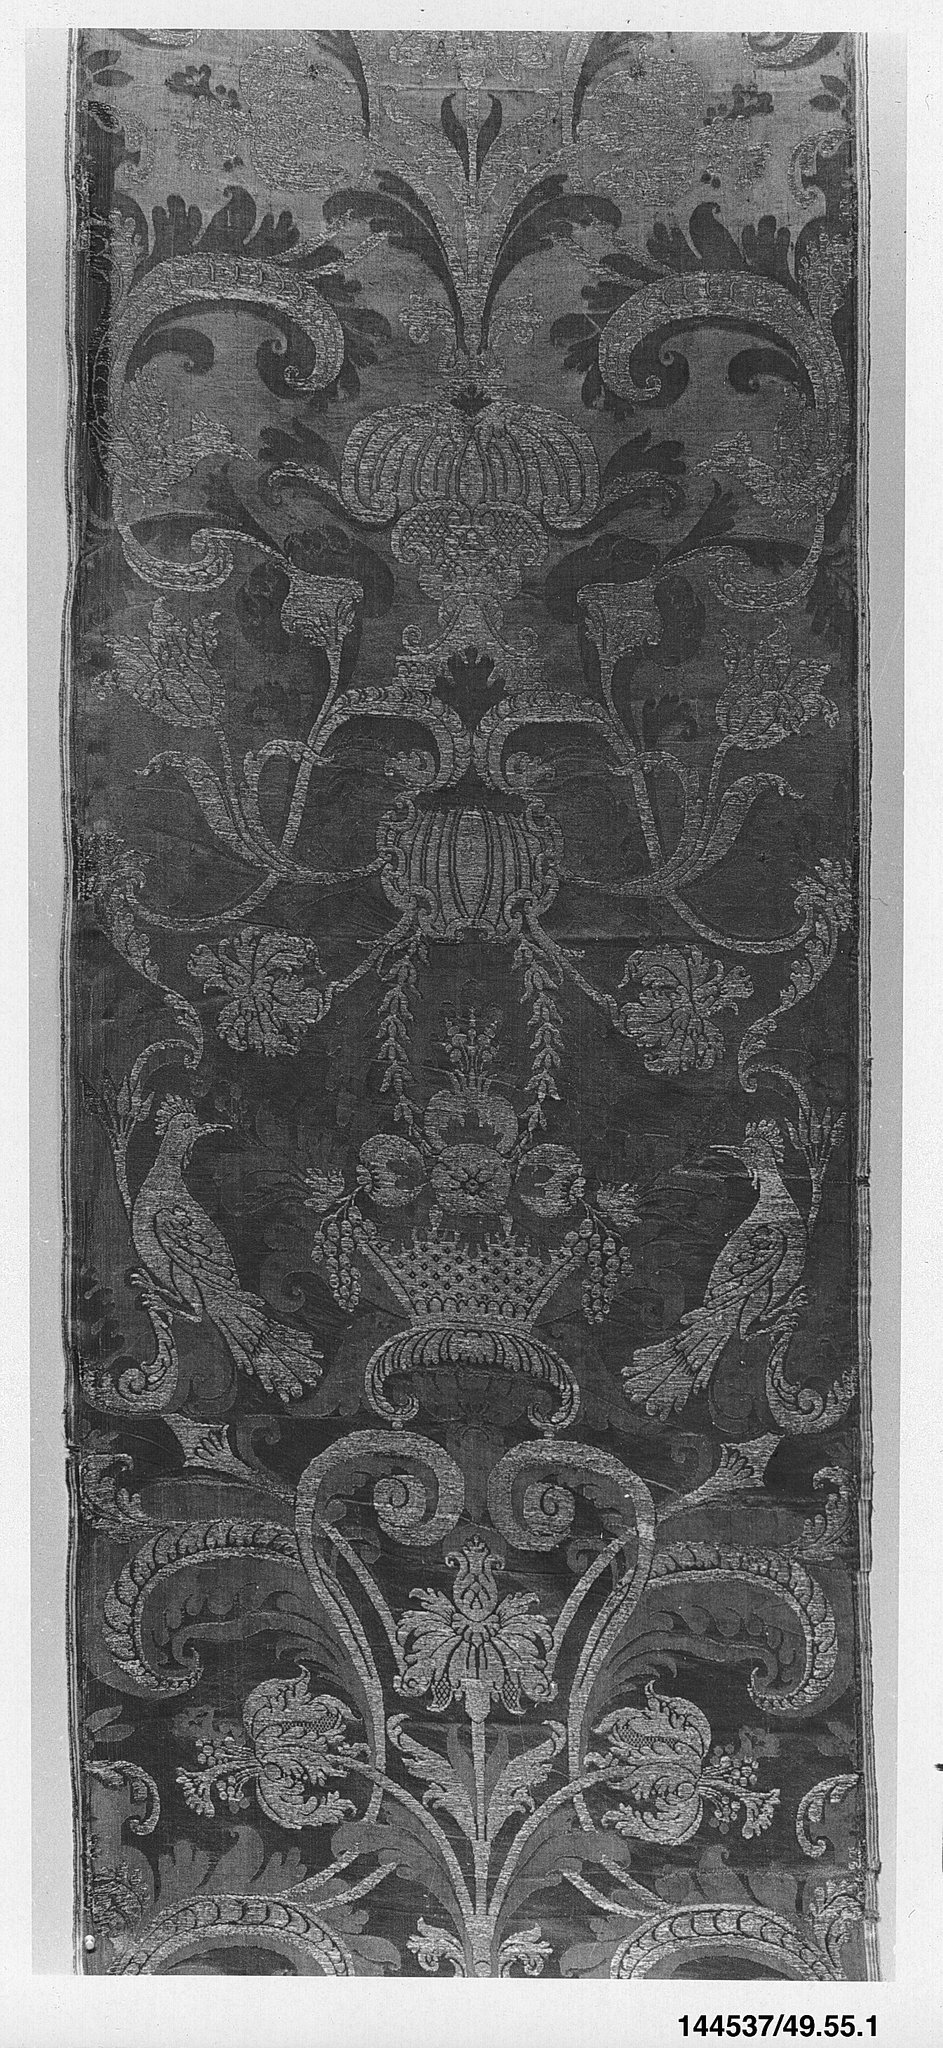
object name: piece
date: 1675-1700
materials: metal thread, silk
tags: birds,flowers,leaves